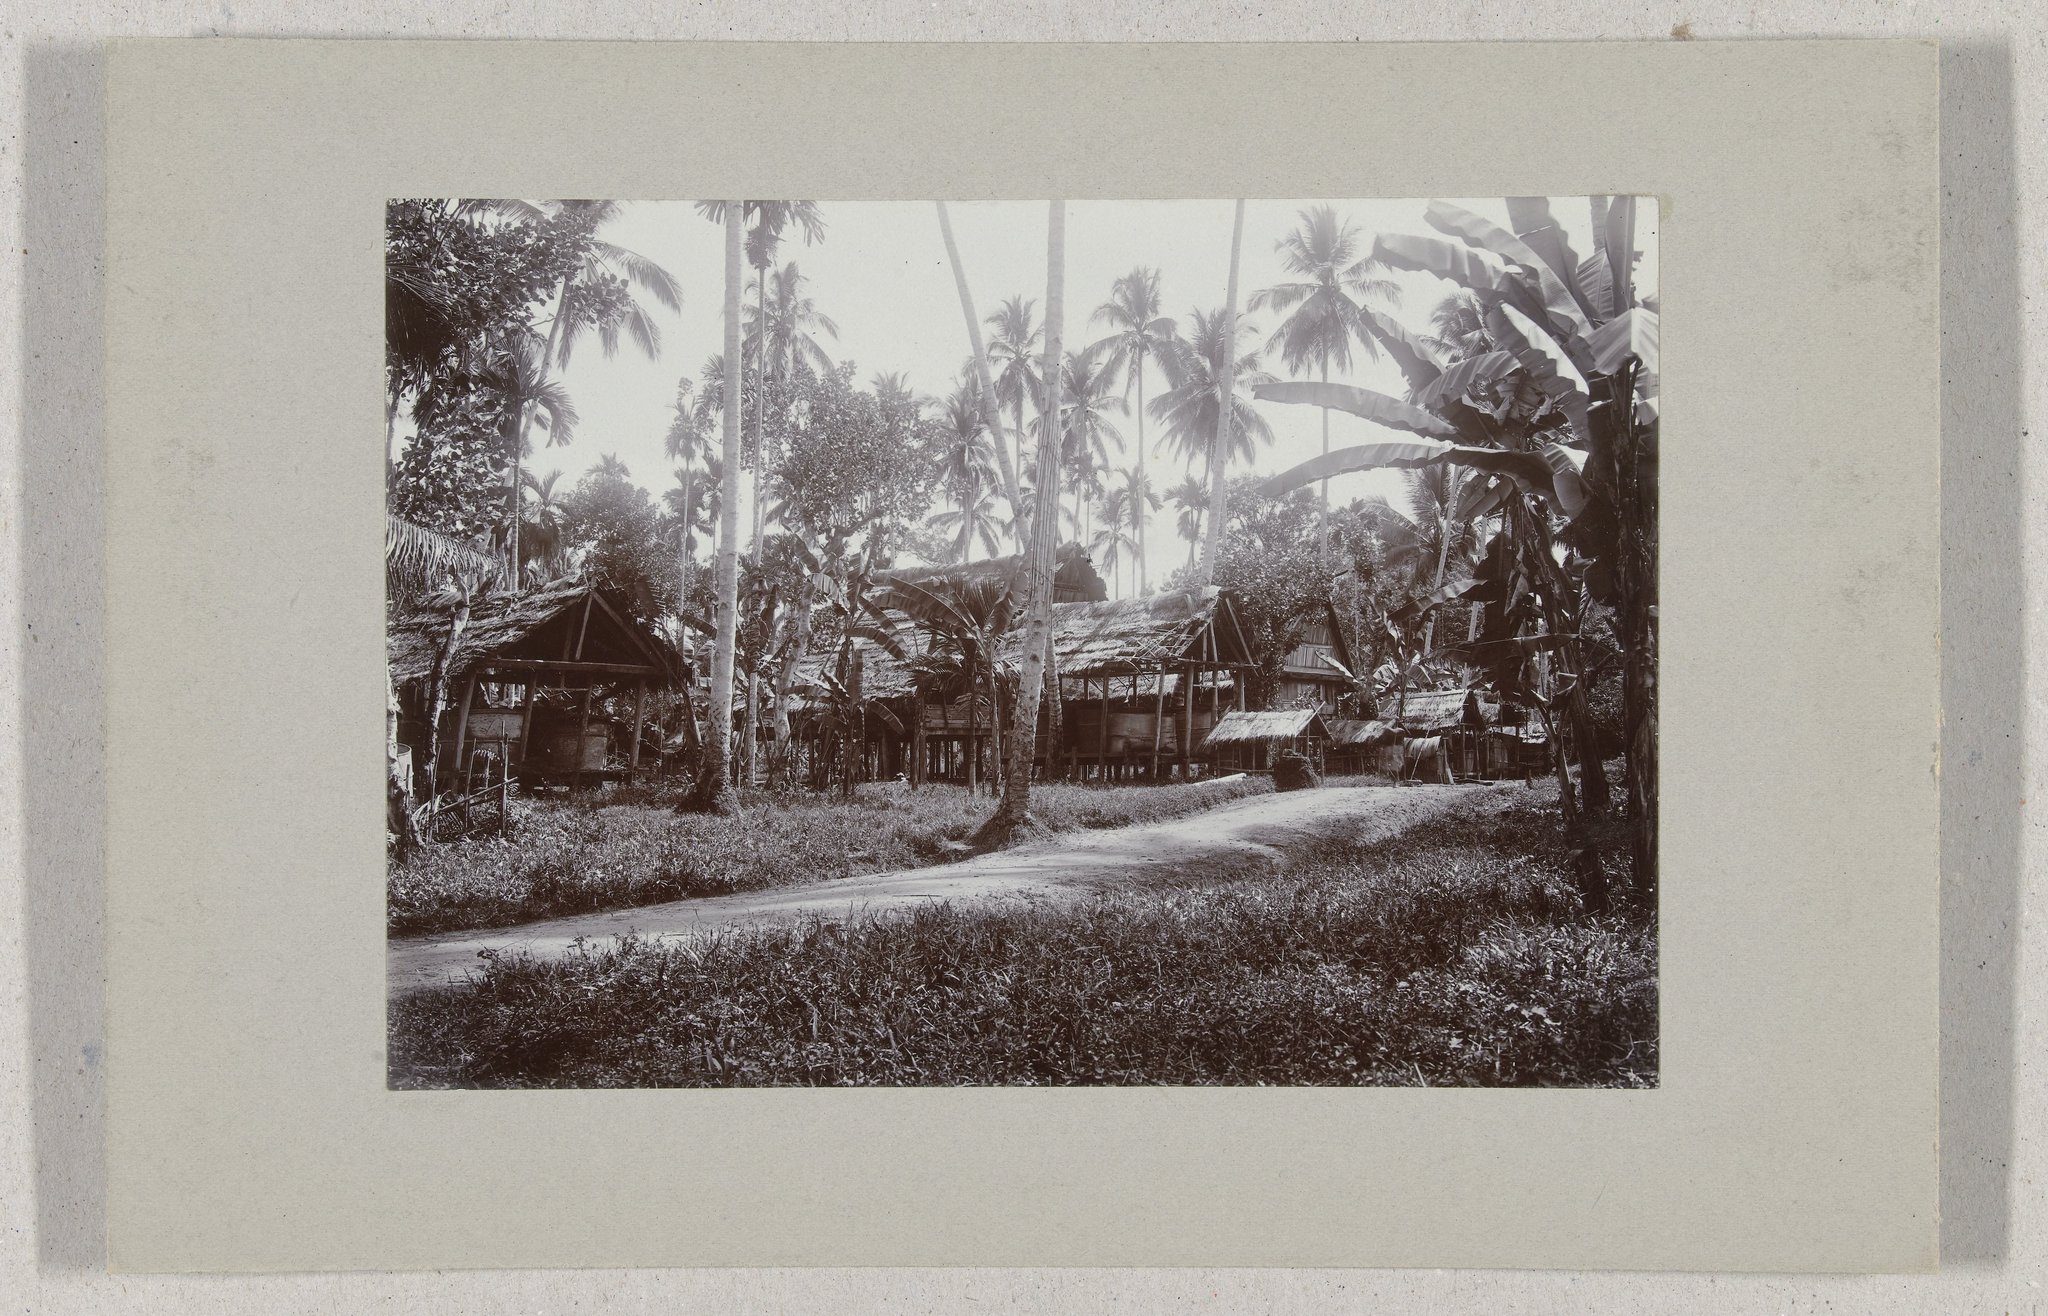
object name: photograph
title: 7b Sumatra-Kampong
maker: Anonymous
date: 1895-1915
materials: cardboard, paper, photographic support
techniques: gelatin silver print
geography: sumatra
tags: indonesia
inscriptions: annotation: ‘7b Sumatra-Kampong’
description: Huizen op palen in een kampong, Sumatra, Nederlands-Indië